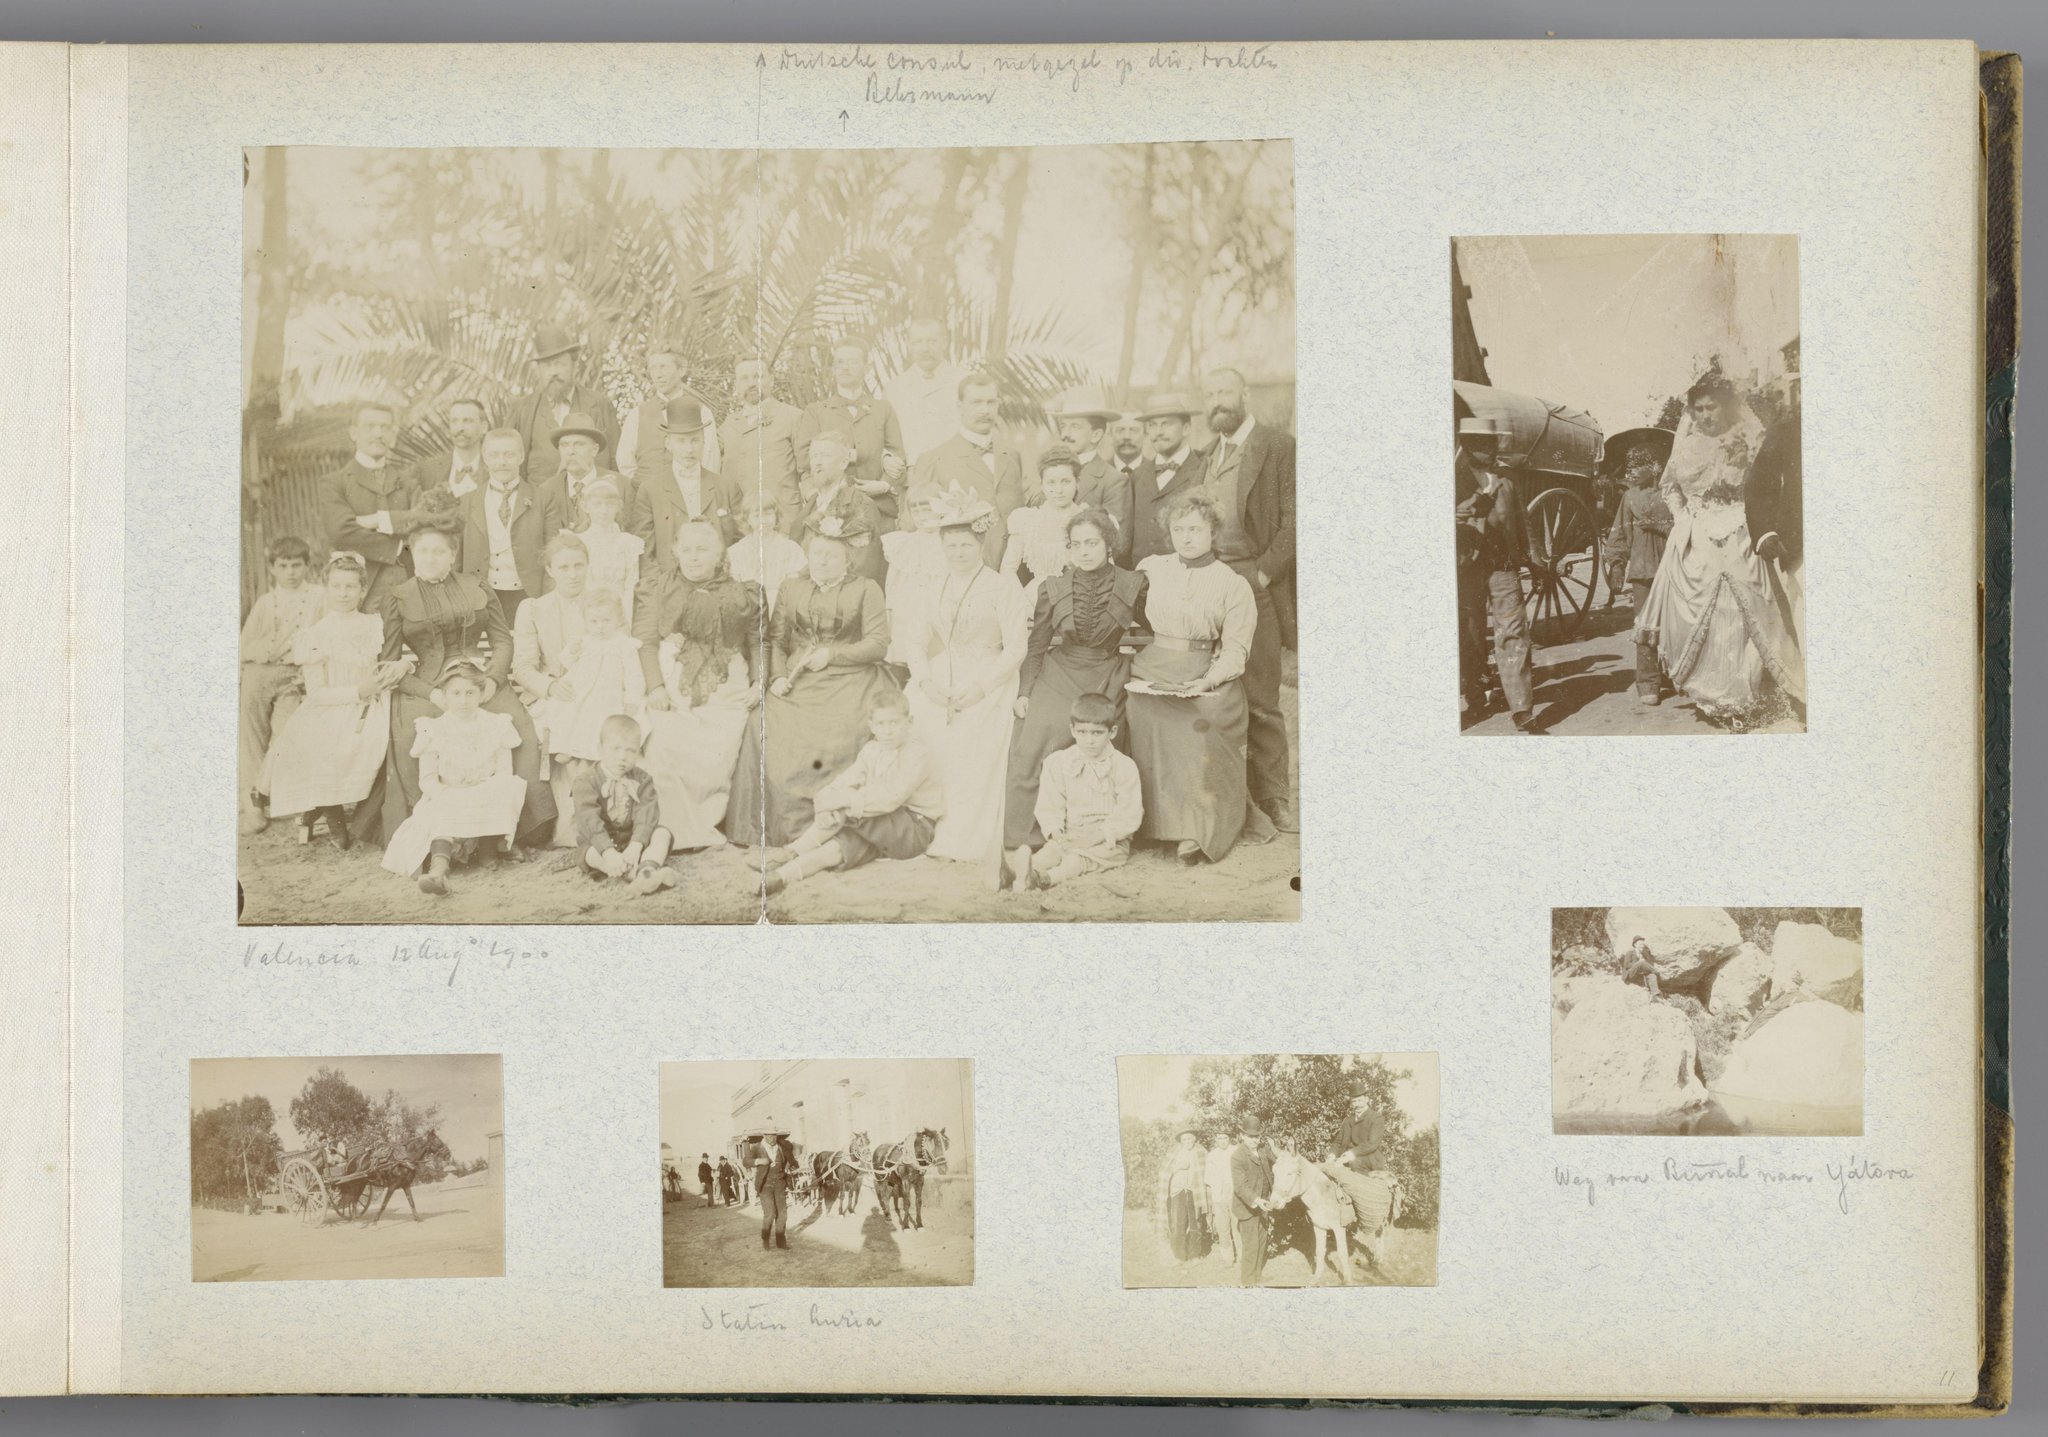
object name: photograph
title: Vakantie in Zwitserland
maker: andries augustus boom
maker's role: amateurfotograaf, handelaar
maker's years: 1878-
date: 1900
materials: paper, photographic support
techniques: photography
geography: spain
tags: amsterdam, andries augustus boom, spain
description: Albumblad met zes foto's in Spanje, o.a. een groepsfoto met de Duitse consul in Valencia, 1900. Onderdeel van het fotoalbum van de familie Boom-Gonggrijp in Suriname en Curaçao.